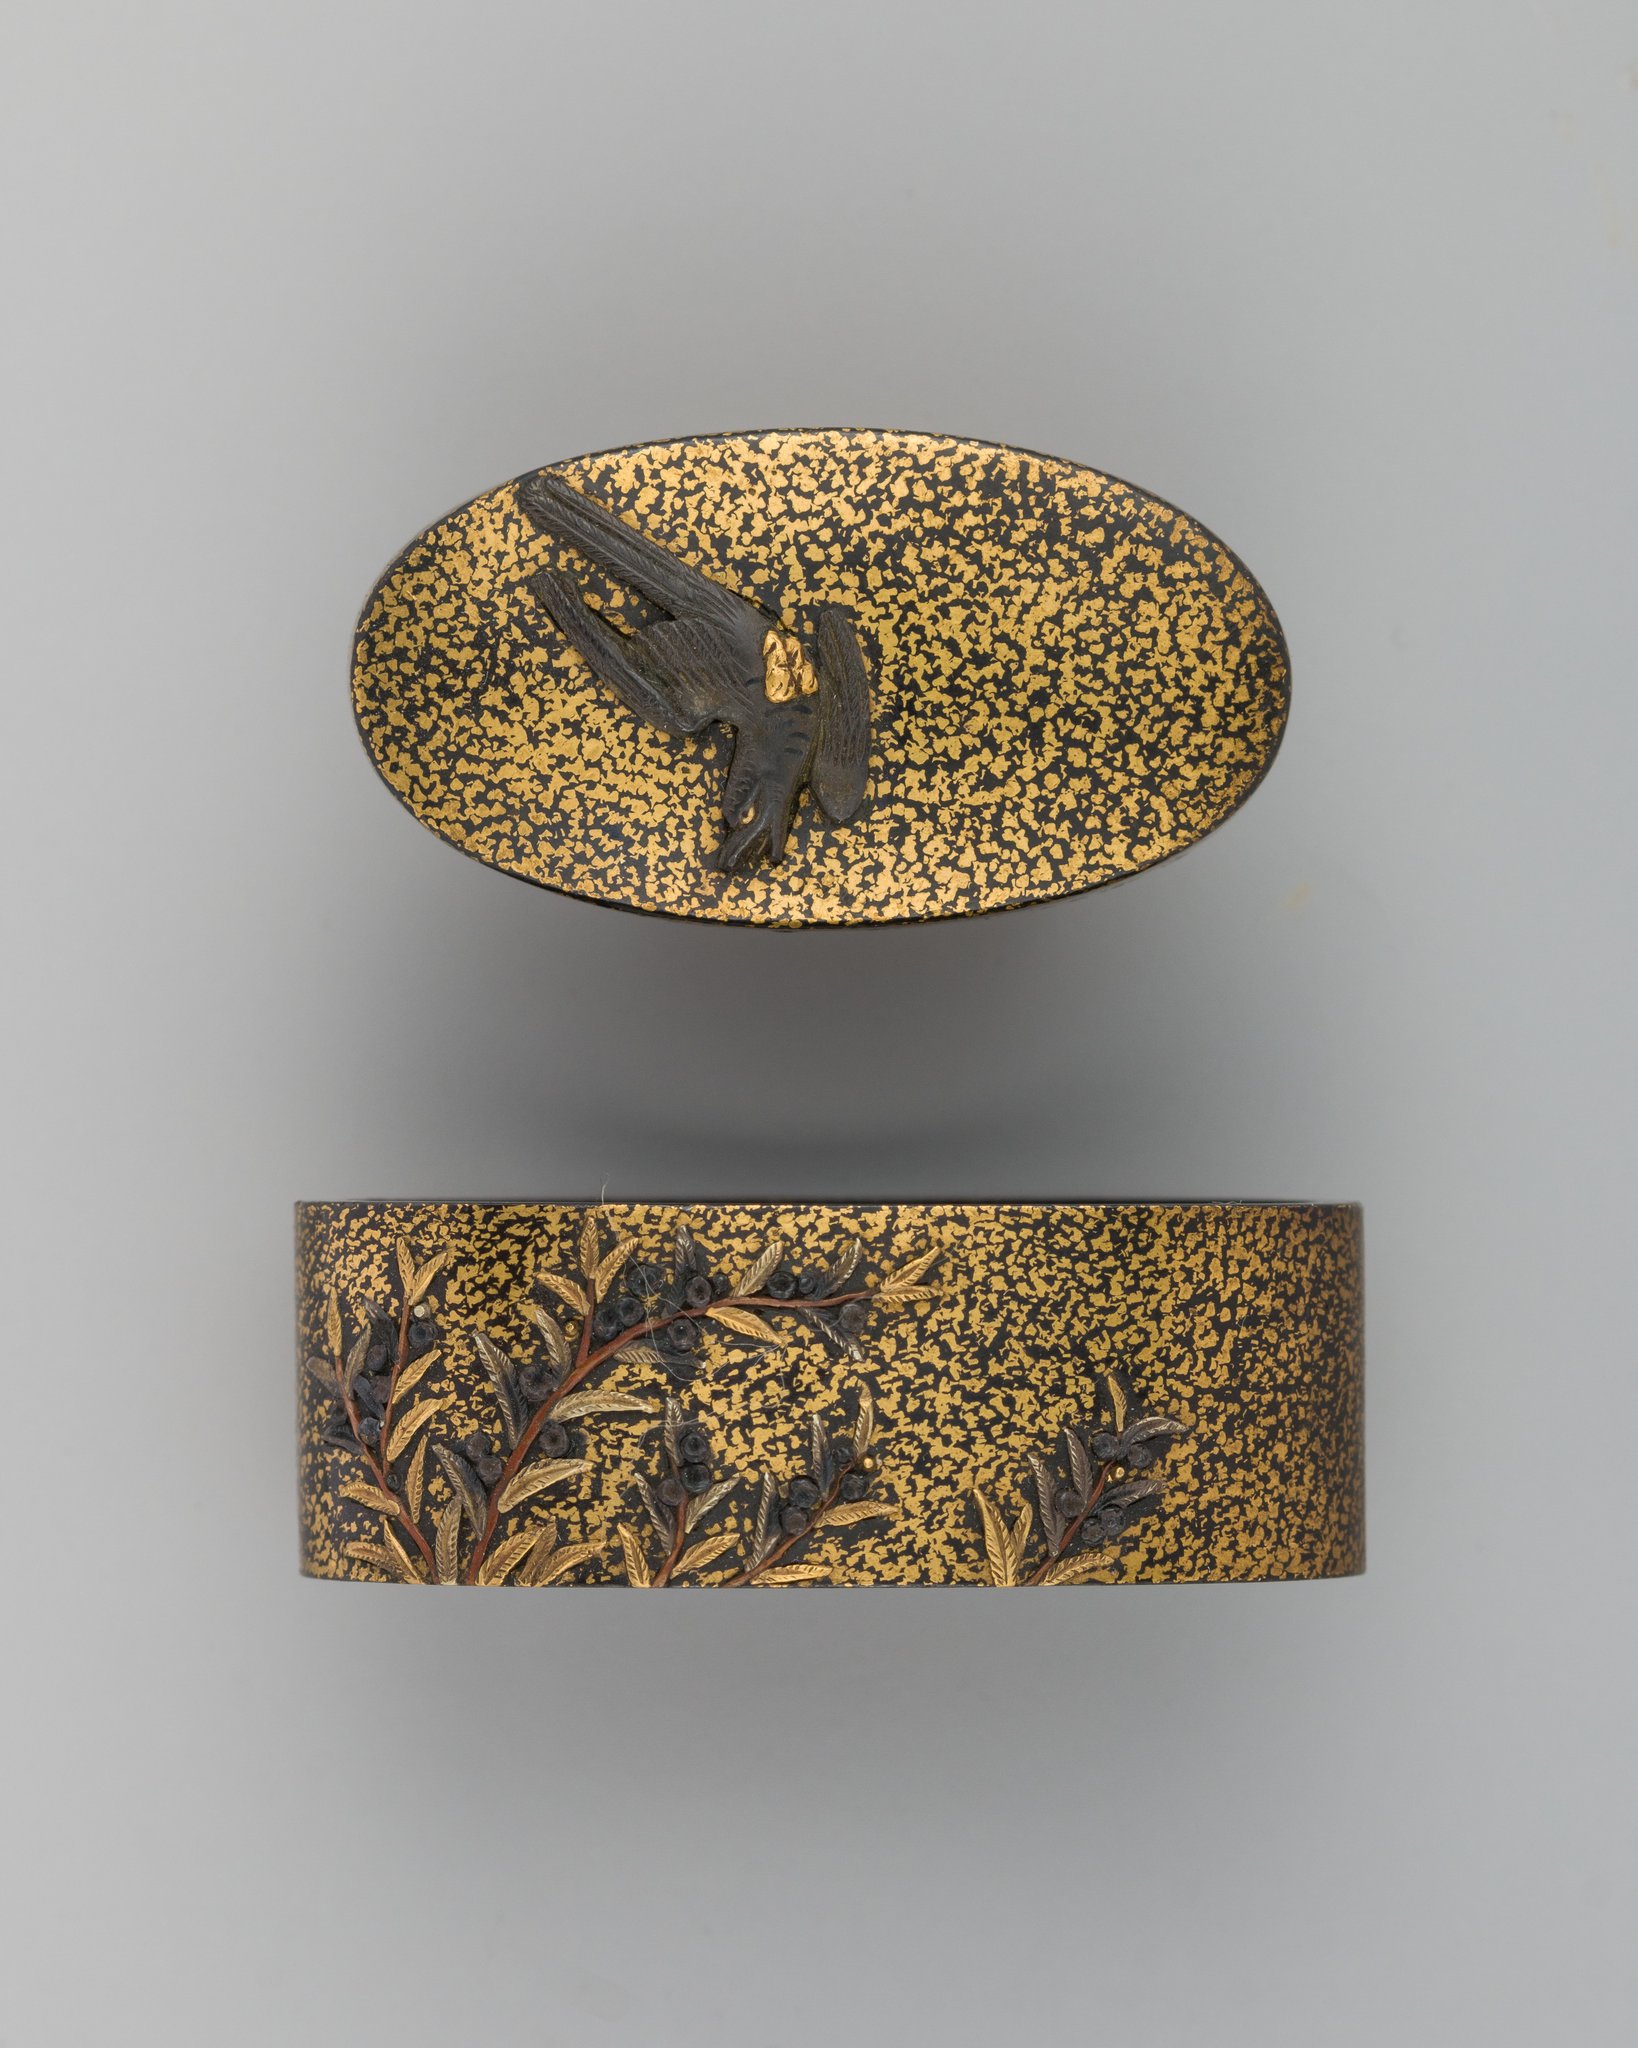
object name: sword hilt collar and pommel fuchigashira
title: Sword-Hilt Collar and Pommel (Fuchigashira)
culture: japanese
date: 1615-1868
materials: copper, gold alloy, gold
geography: japan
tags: birds,leaves